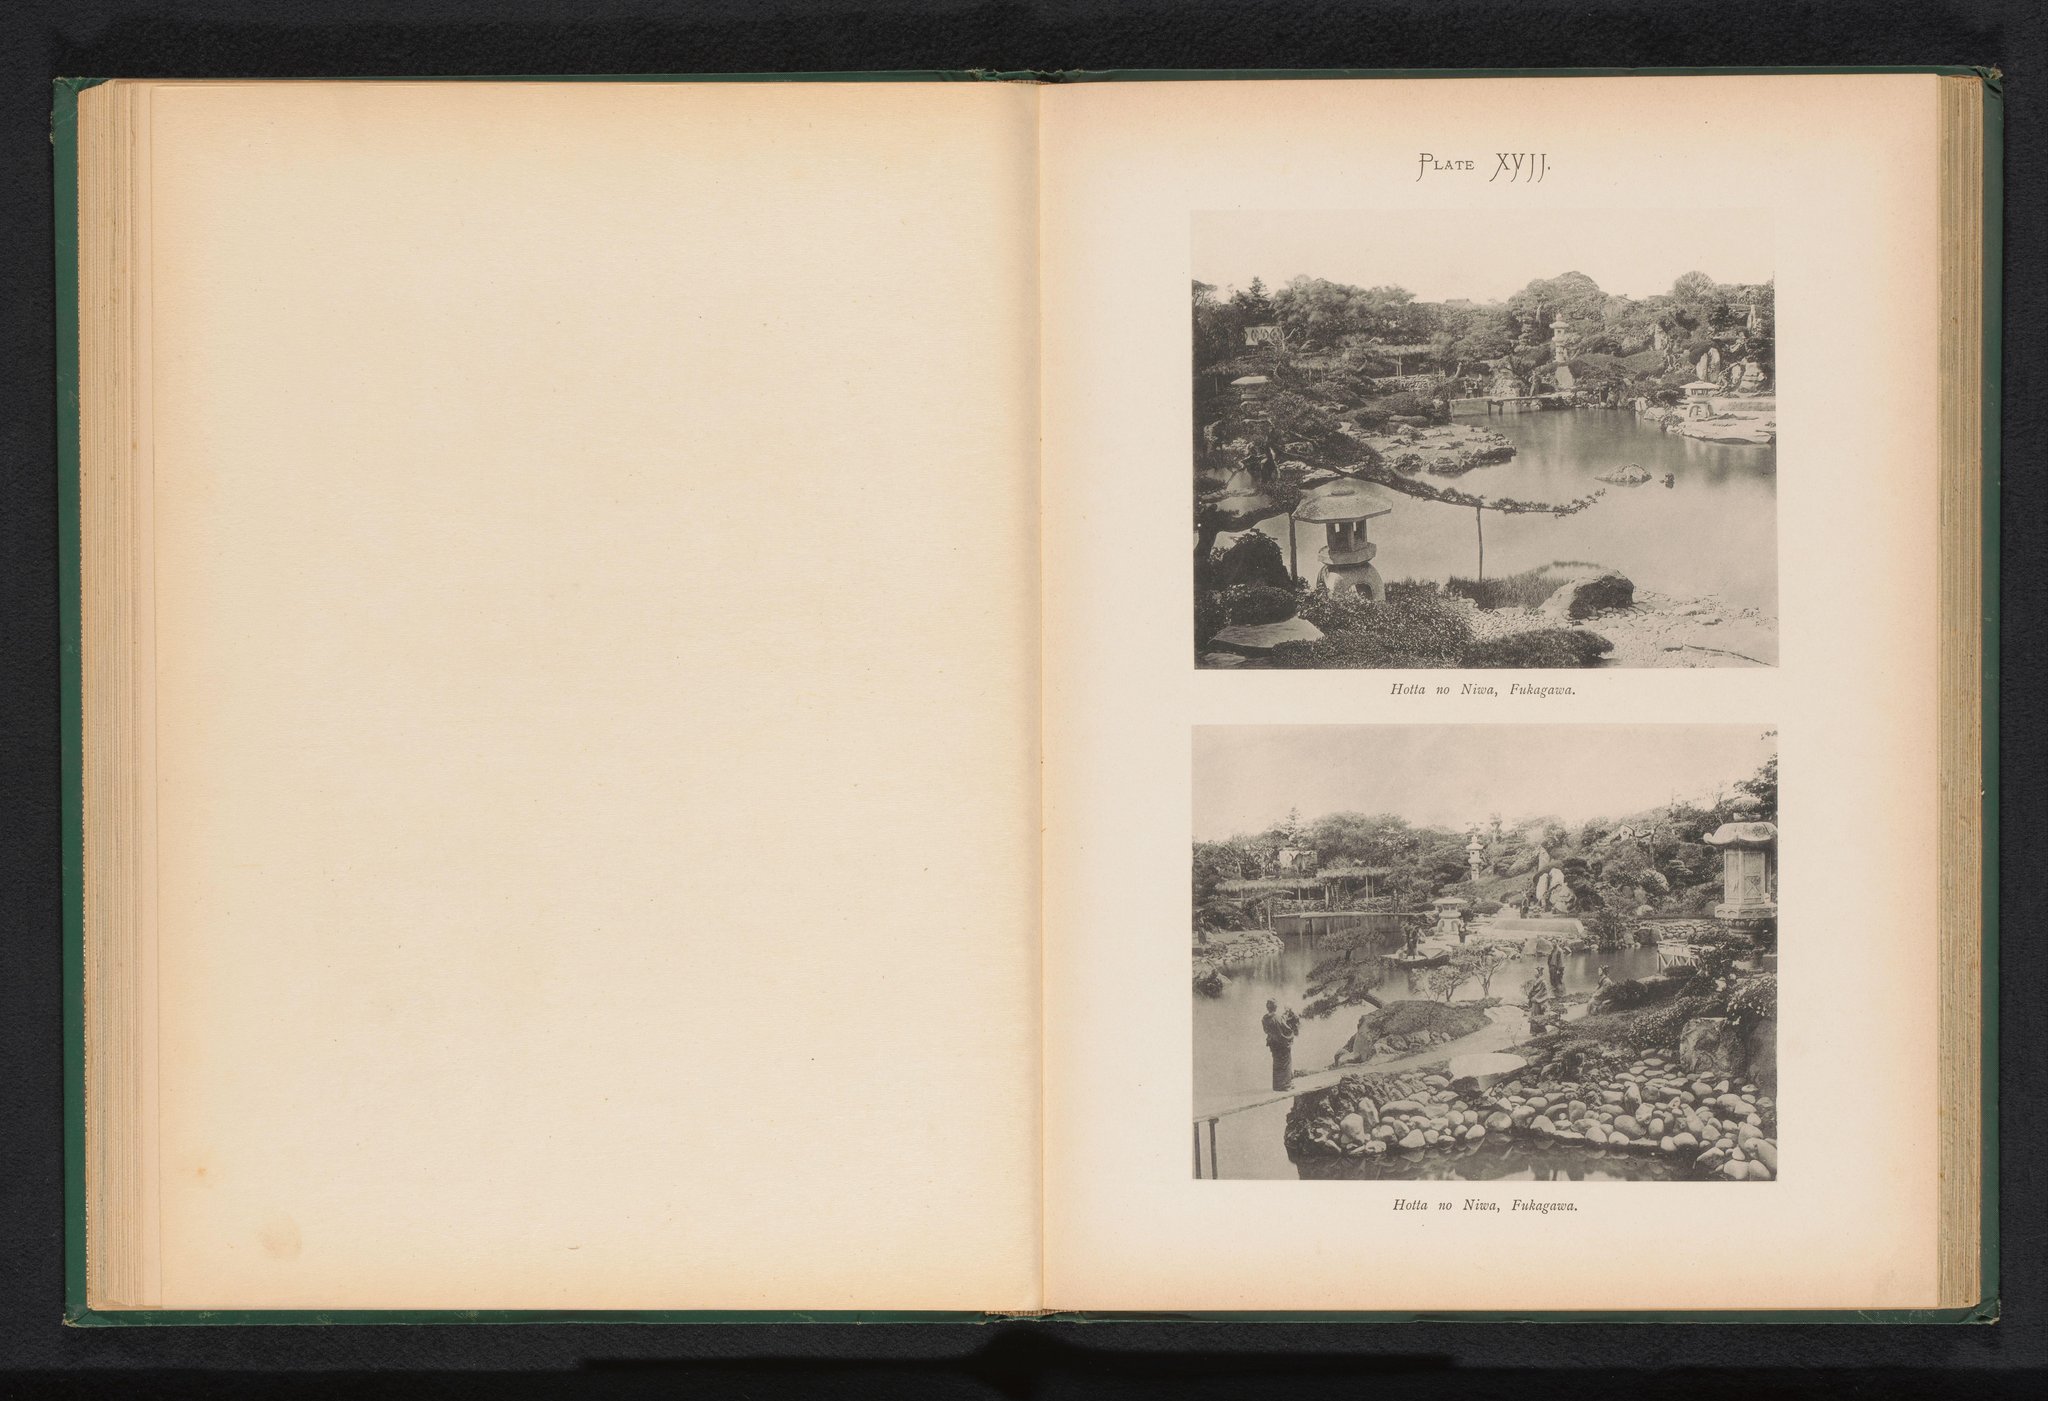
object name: photomechanical print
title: Hotta no Niwa, Fukagawa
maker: kazumasa ogawa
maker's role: auteur, fotograaf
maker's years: 1860-1929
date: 1888-1893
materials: paper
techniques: photograph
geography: tokyo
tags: garden, pond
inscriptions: inscription: ‘Plate XVII.’